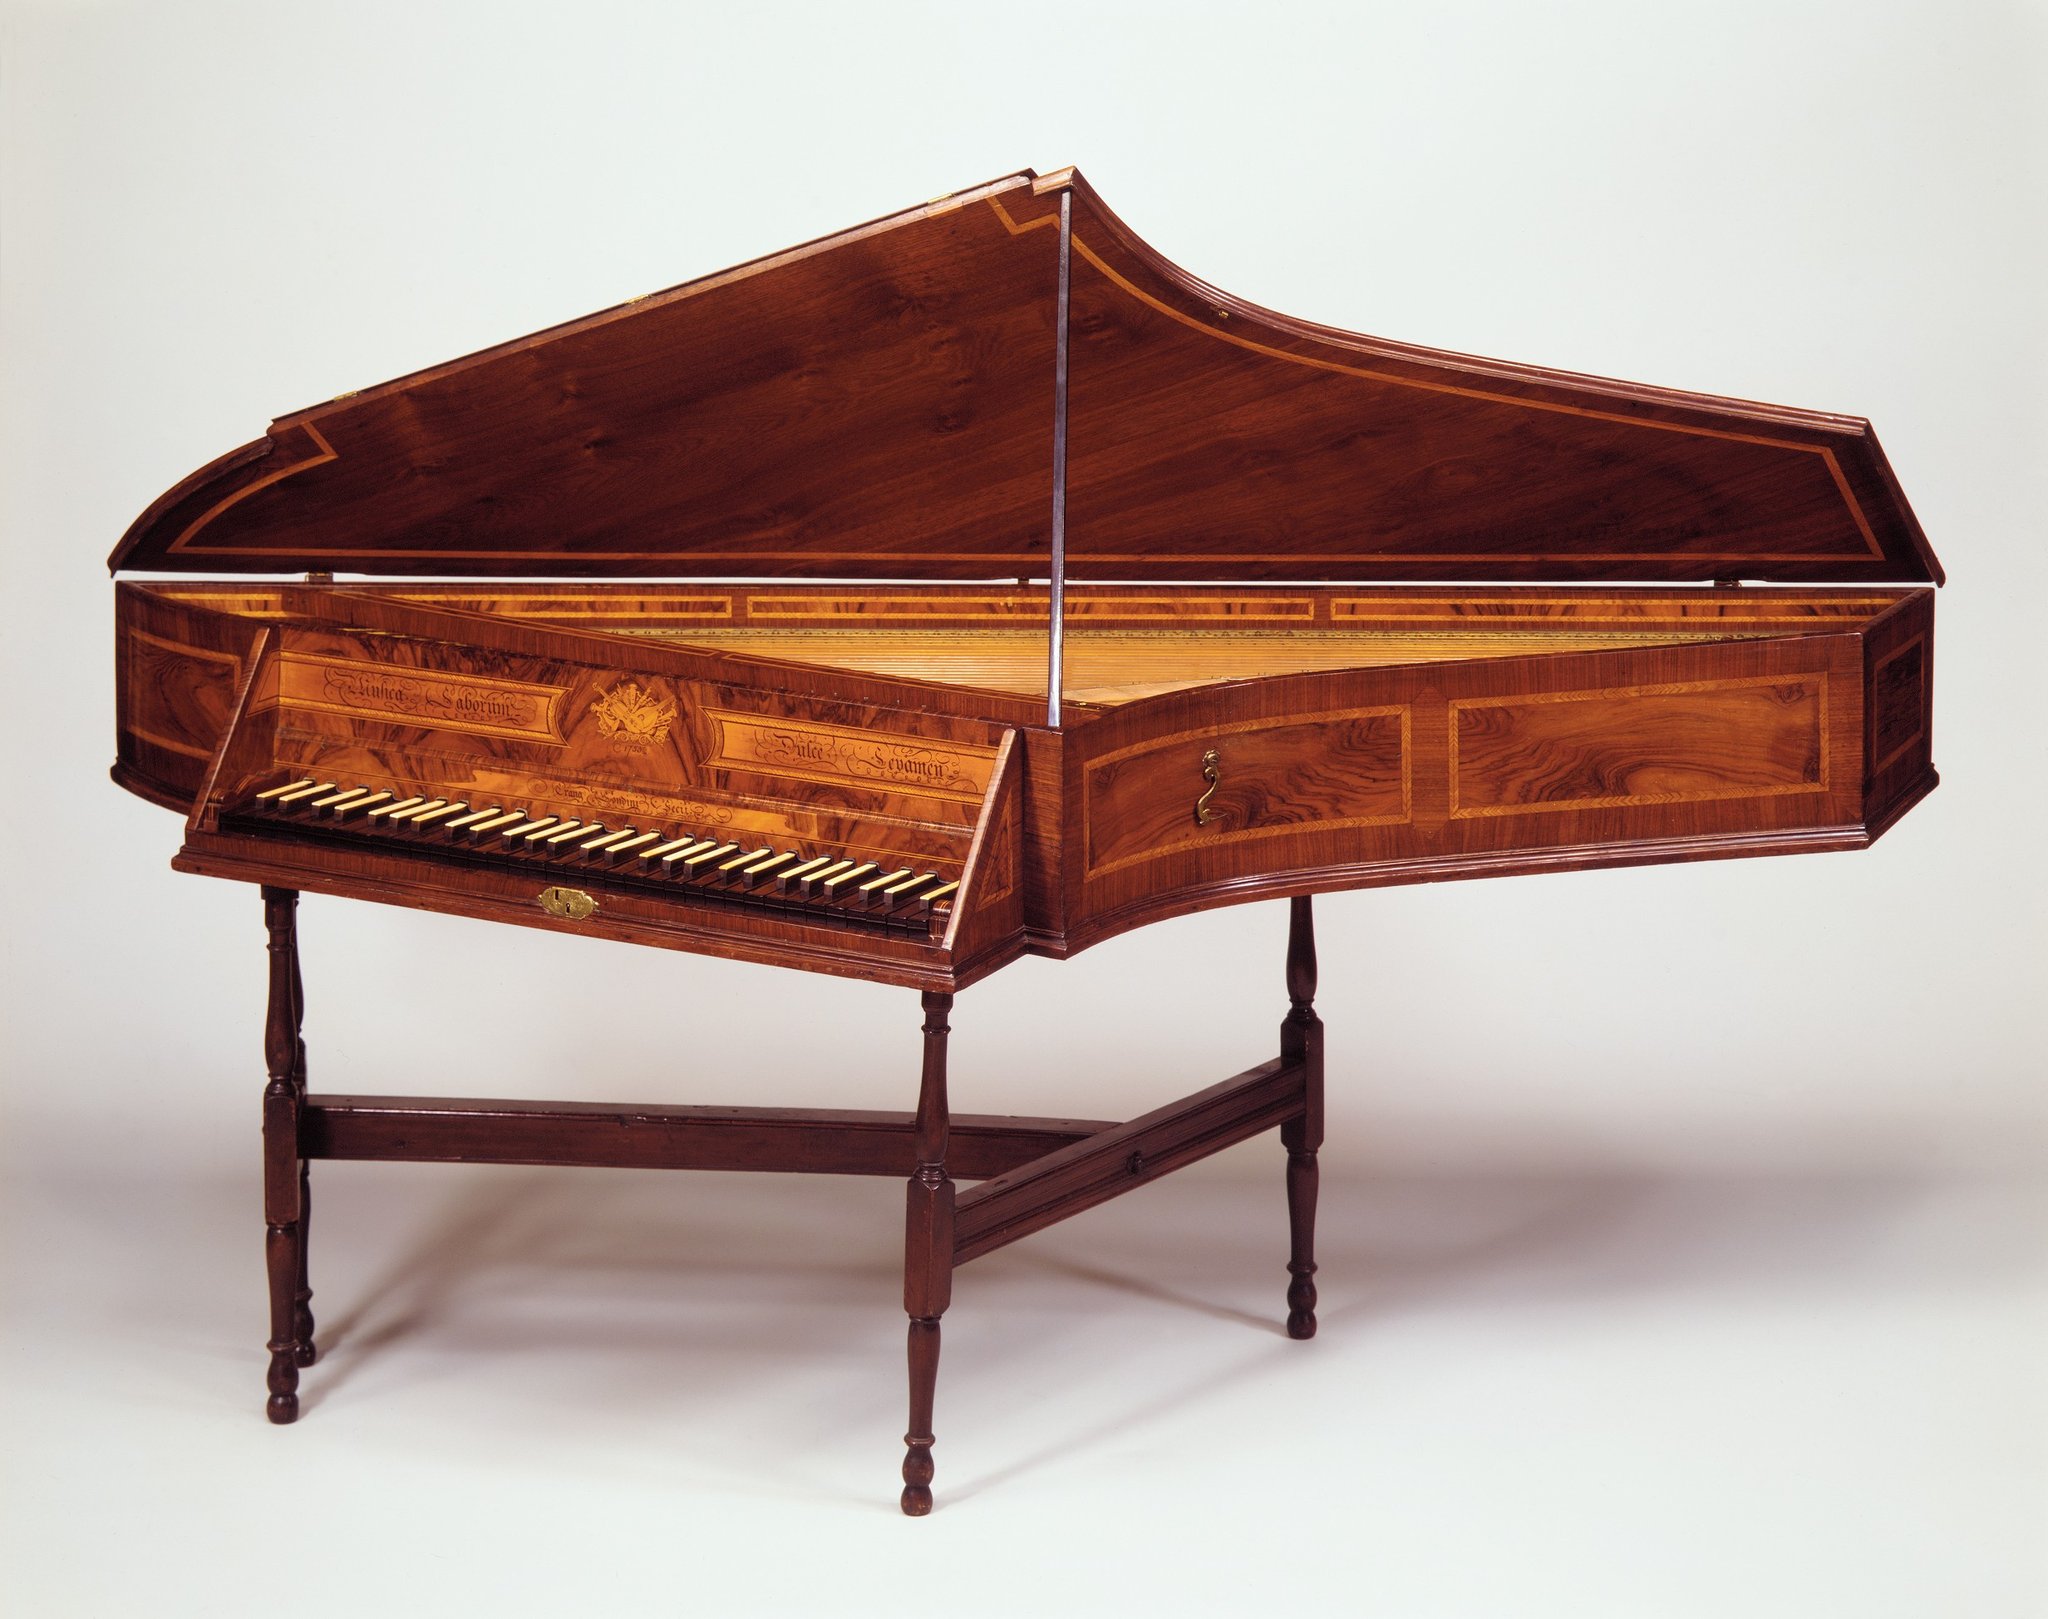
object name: bentside spinet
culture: british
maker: john crang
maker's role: maker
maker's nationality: british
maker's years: 1710-1774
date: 1753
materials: wood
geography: england